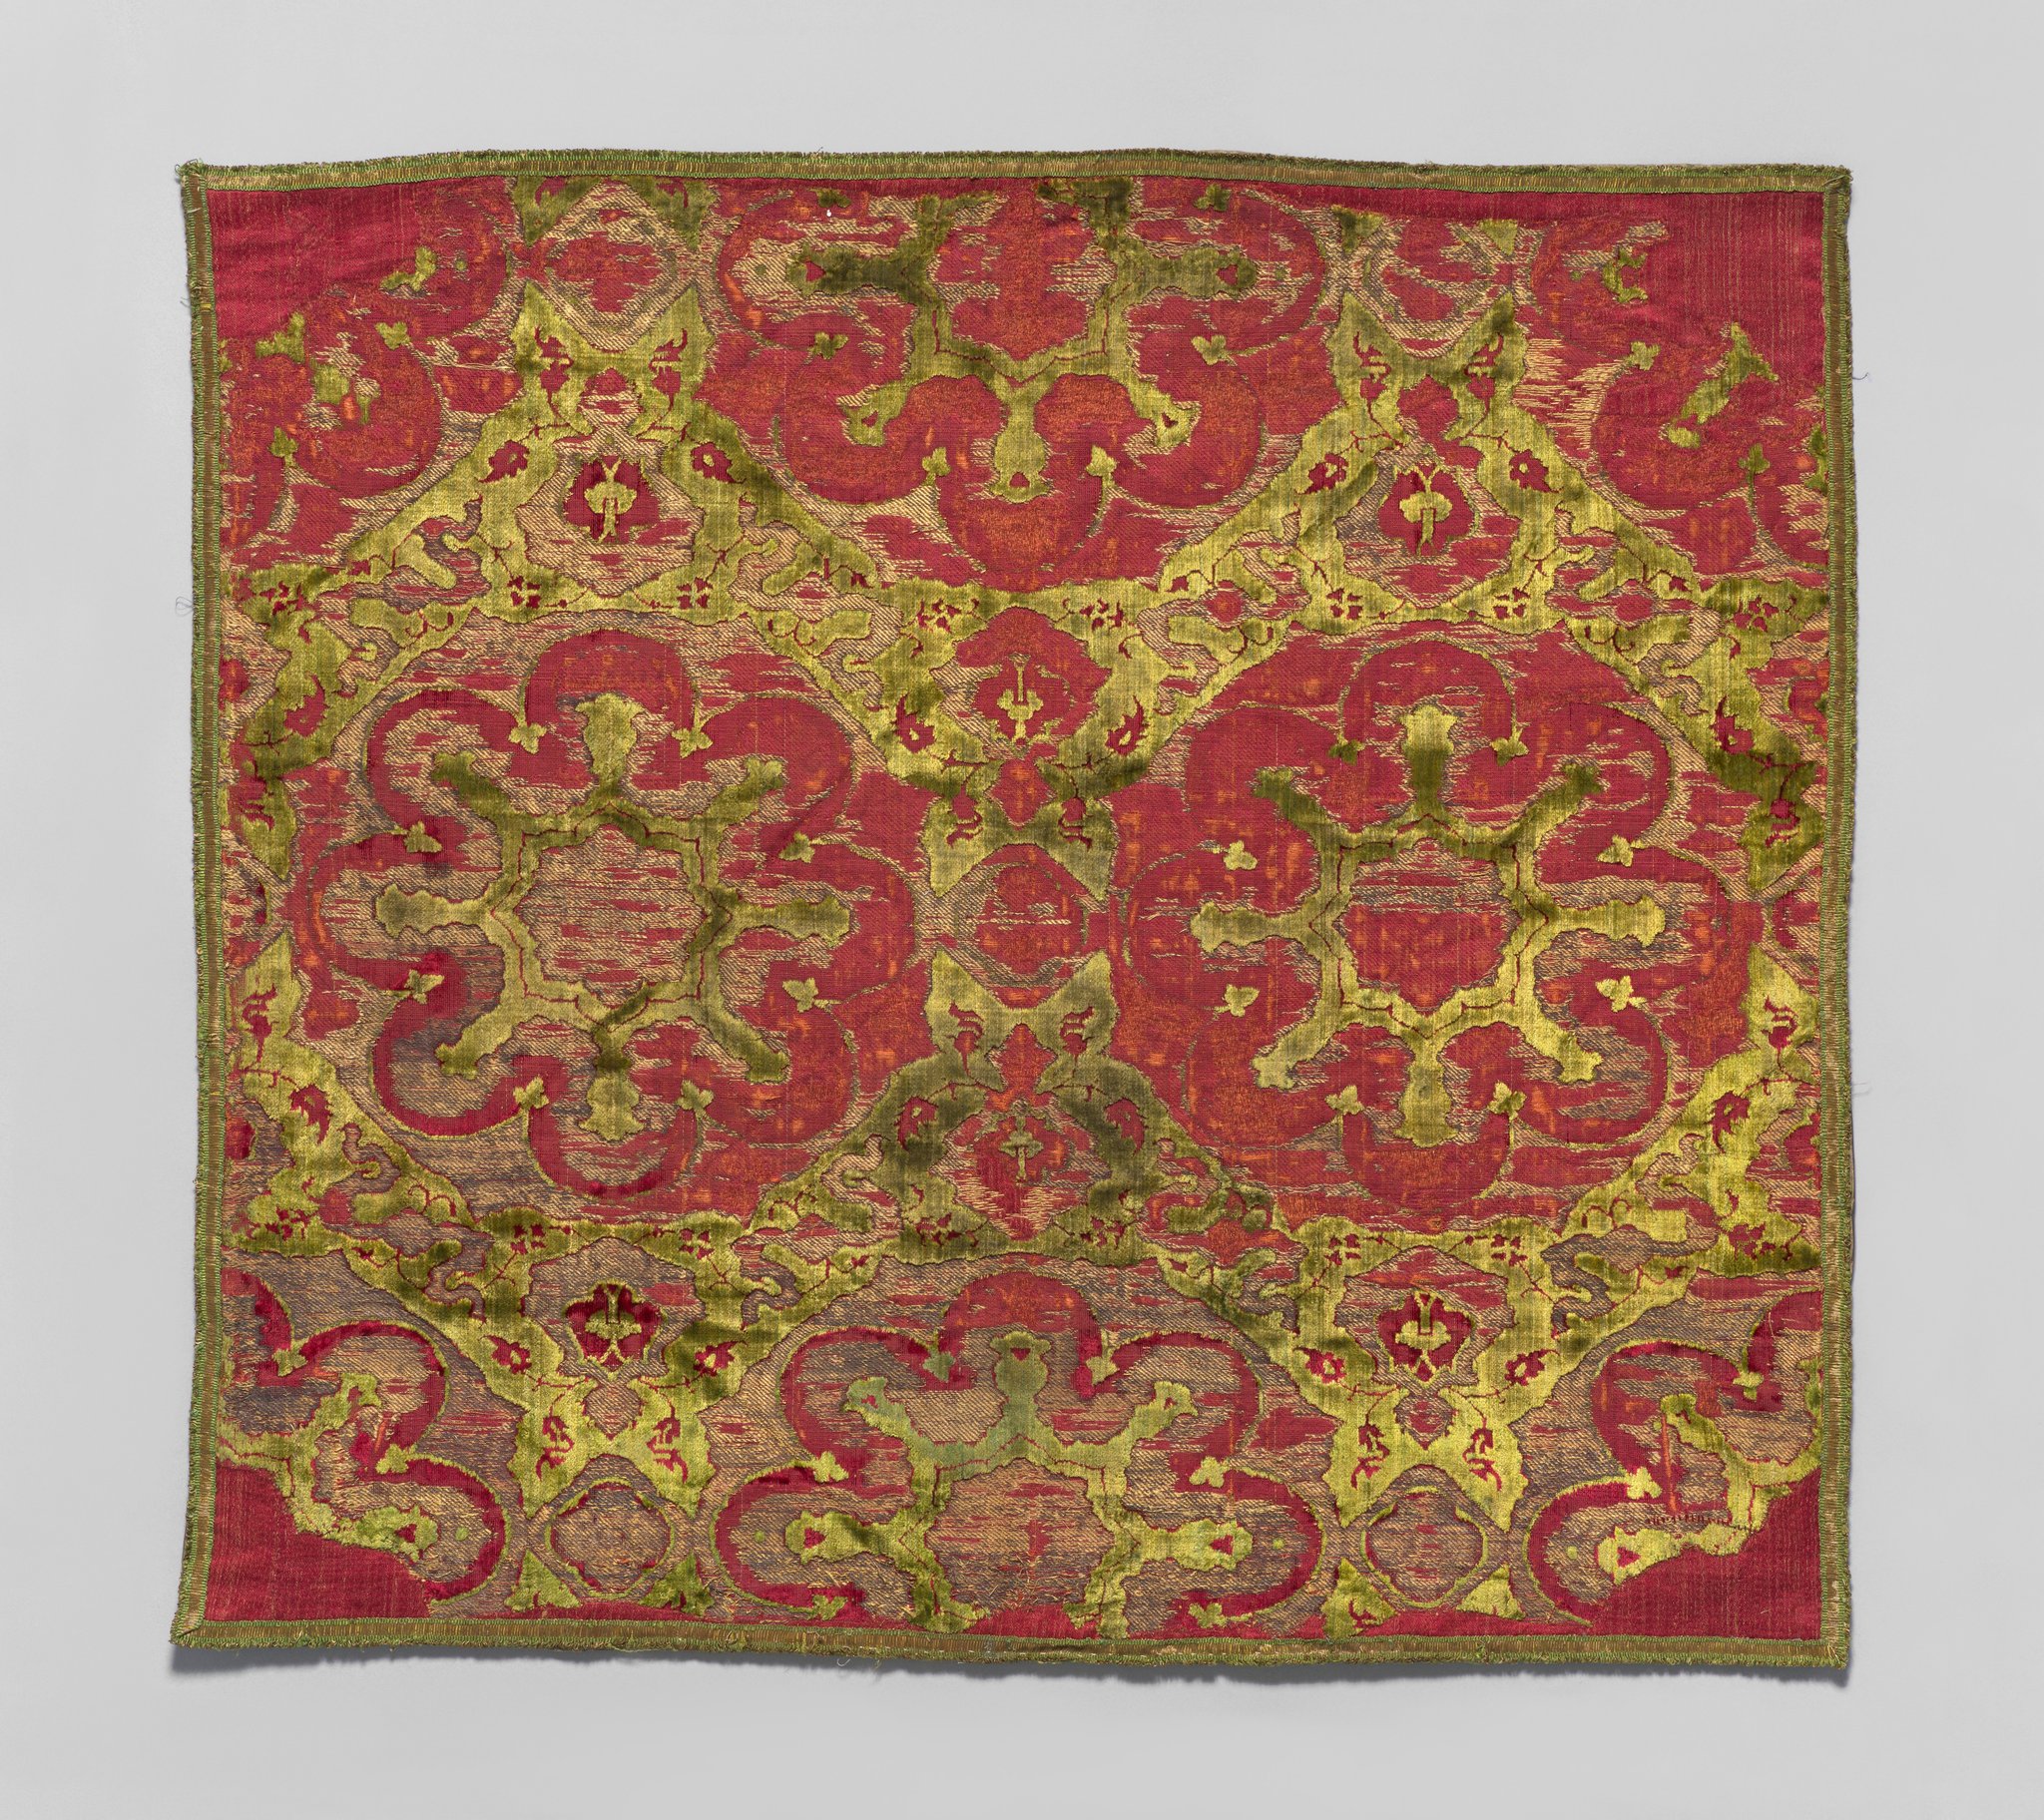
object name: panel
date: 1551-1600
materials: metal thread, silk